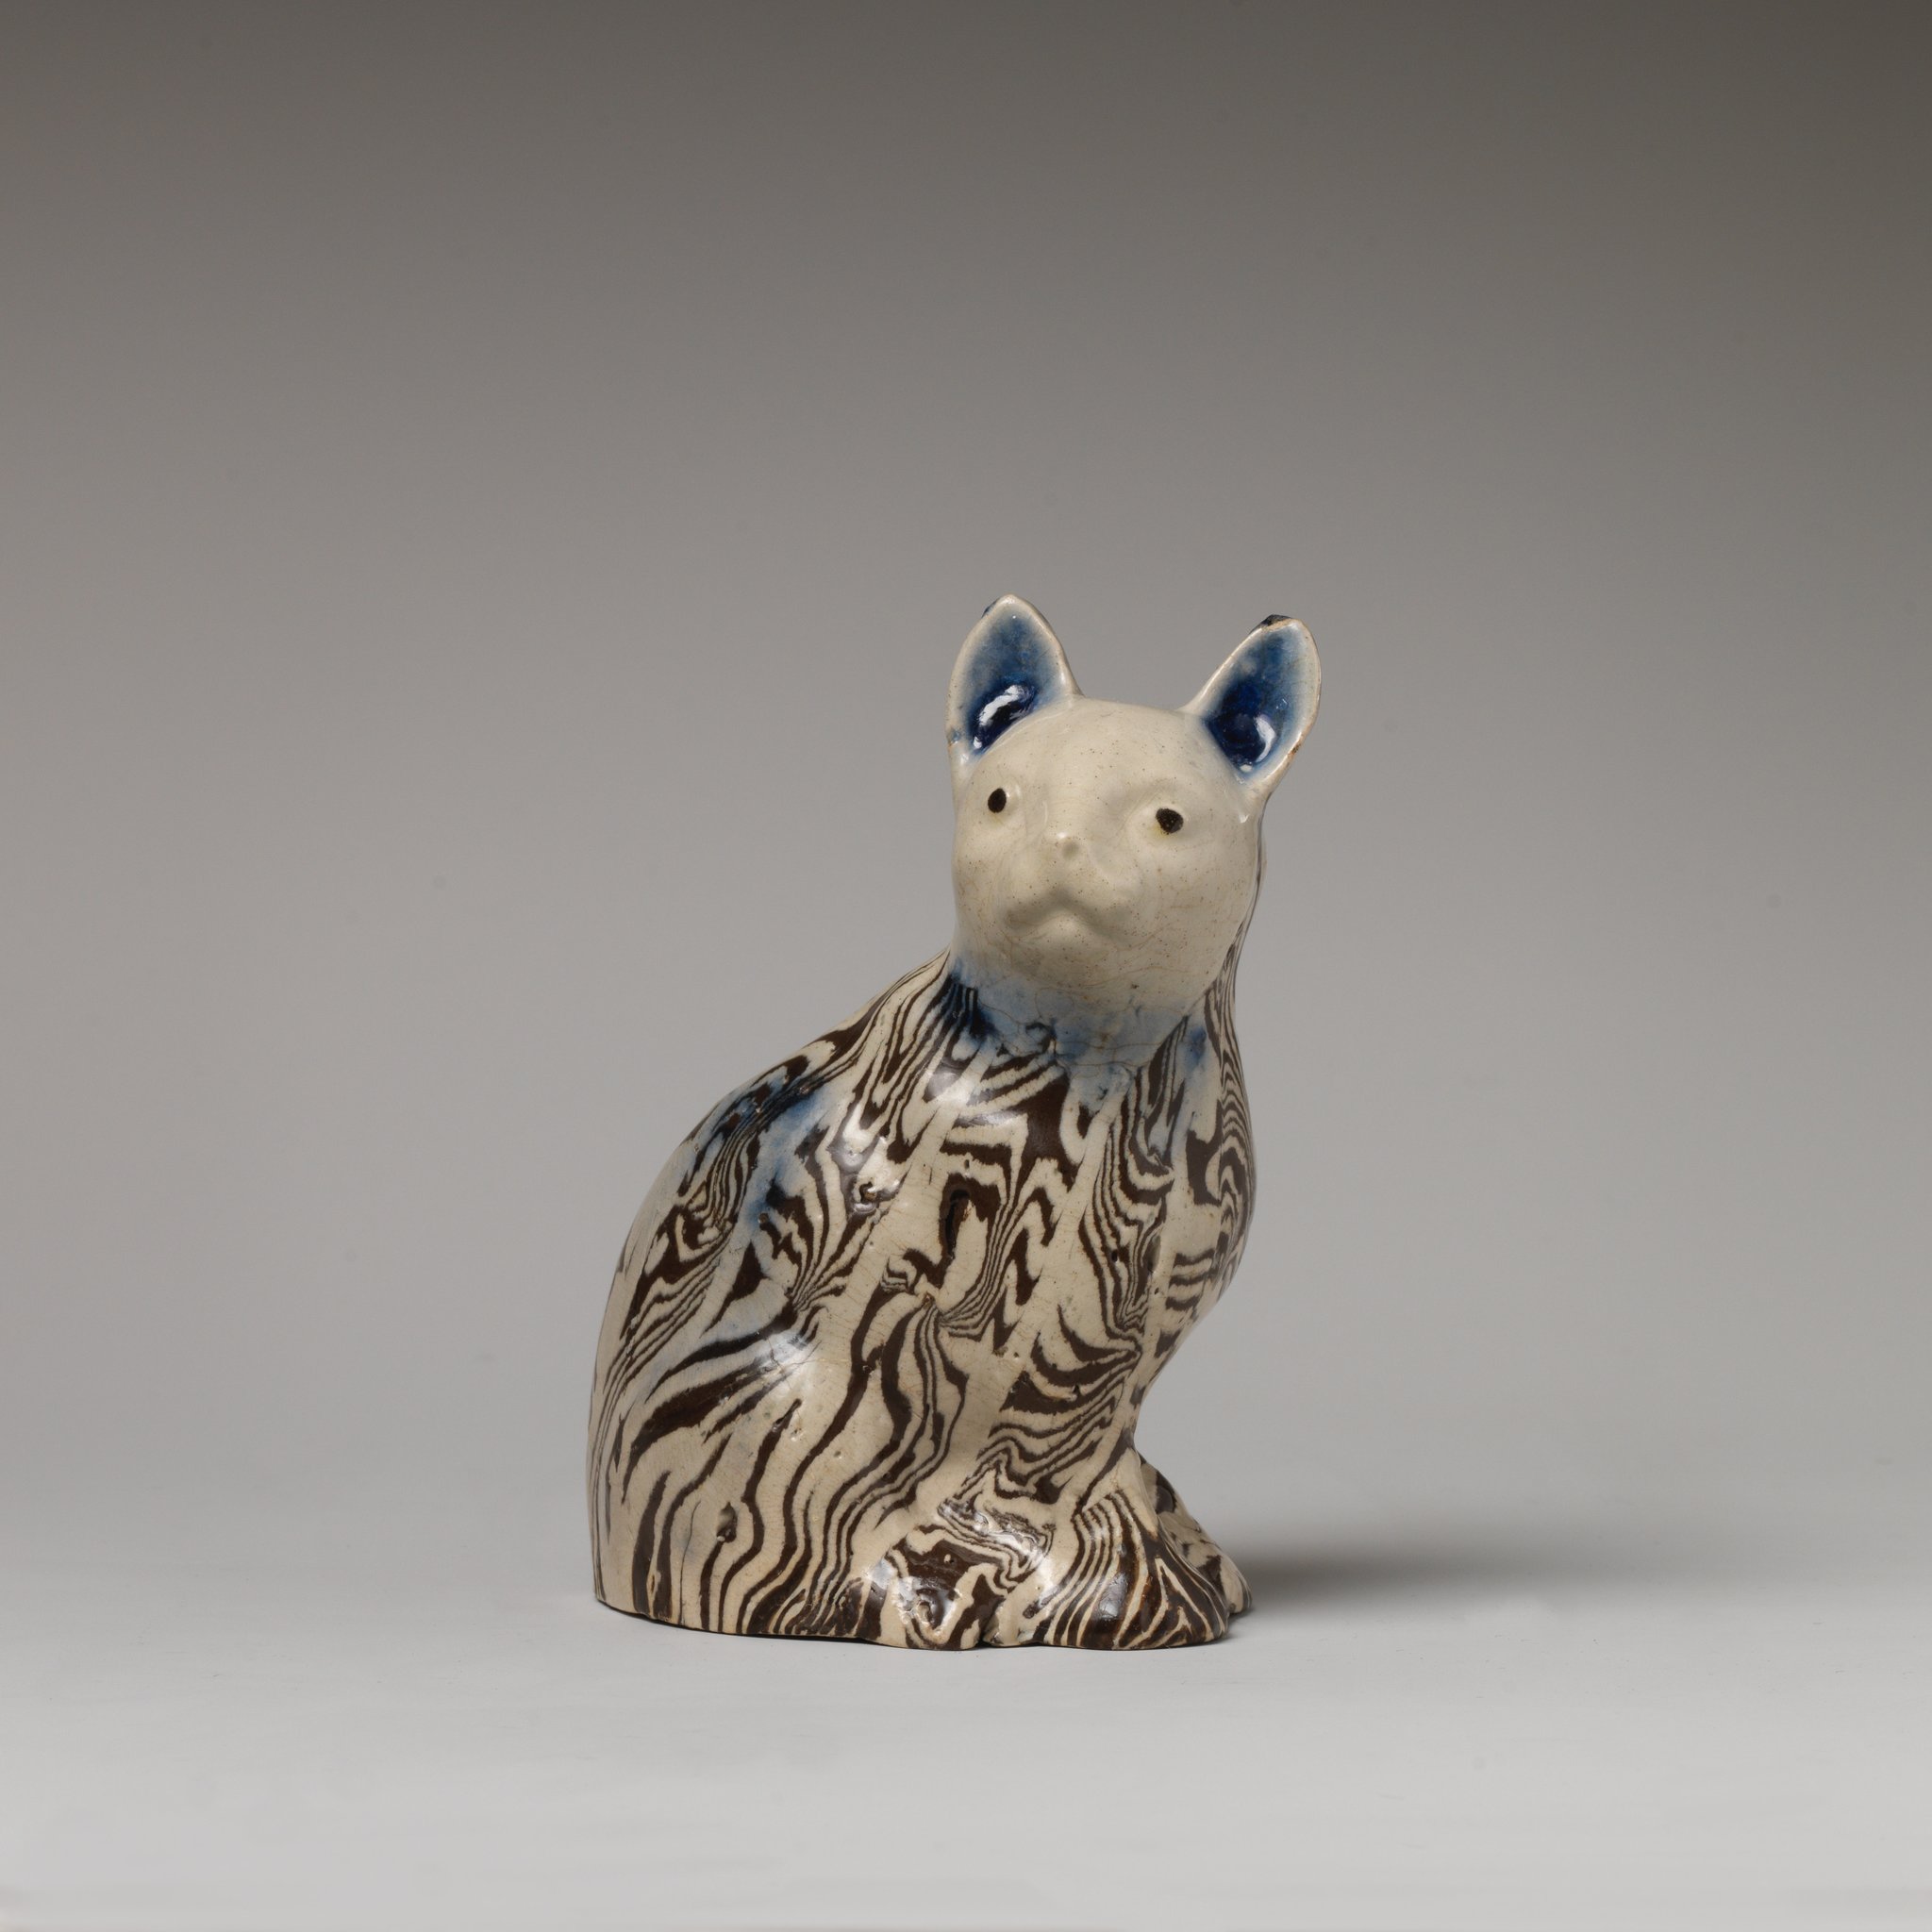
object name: figure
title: Cat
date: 1745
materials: stoneware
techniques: salt glaze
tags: cats